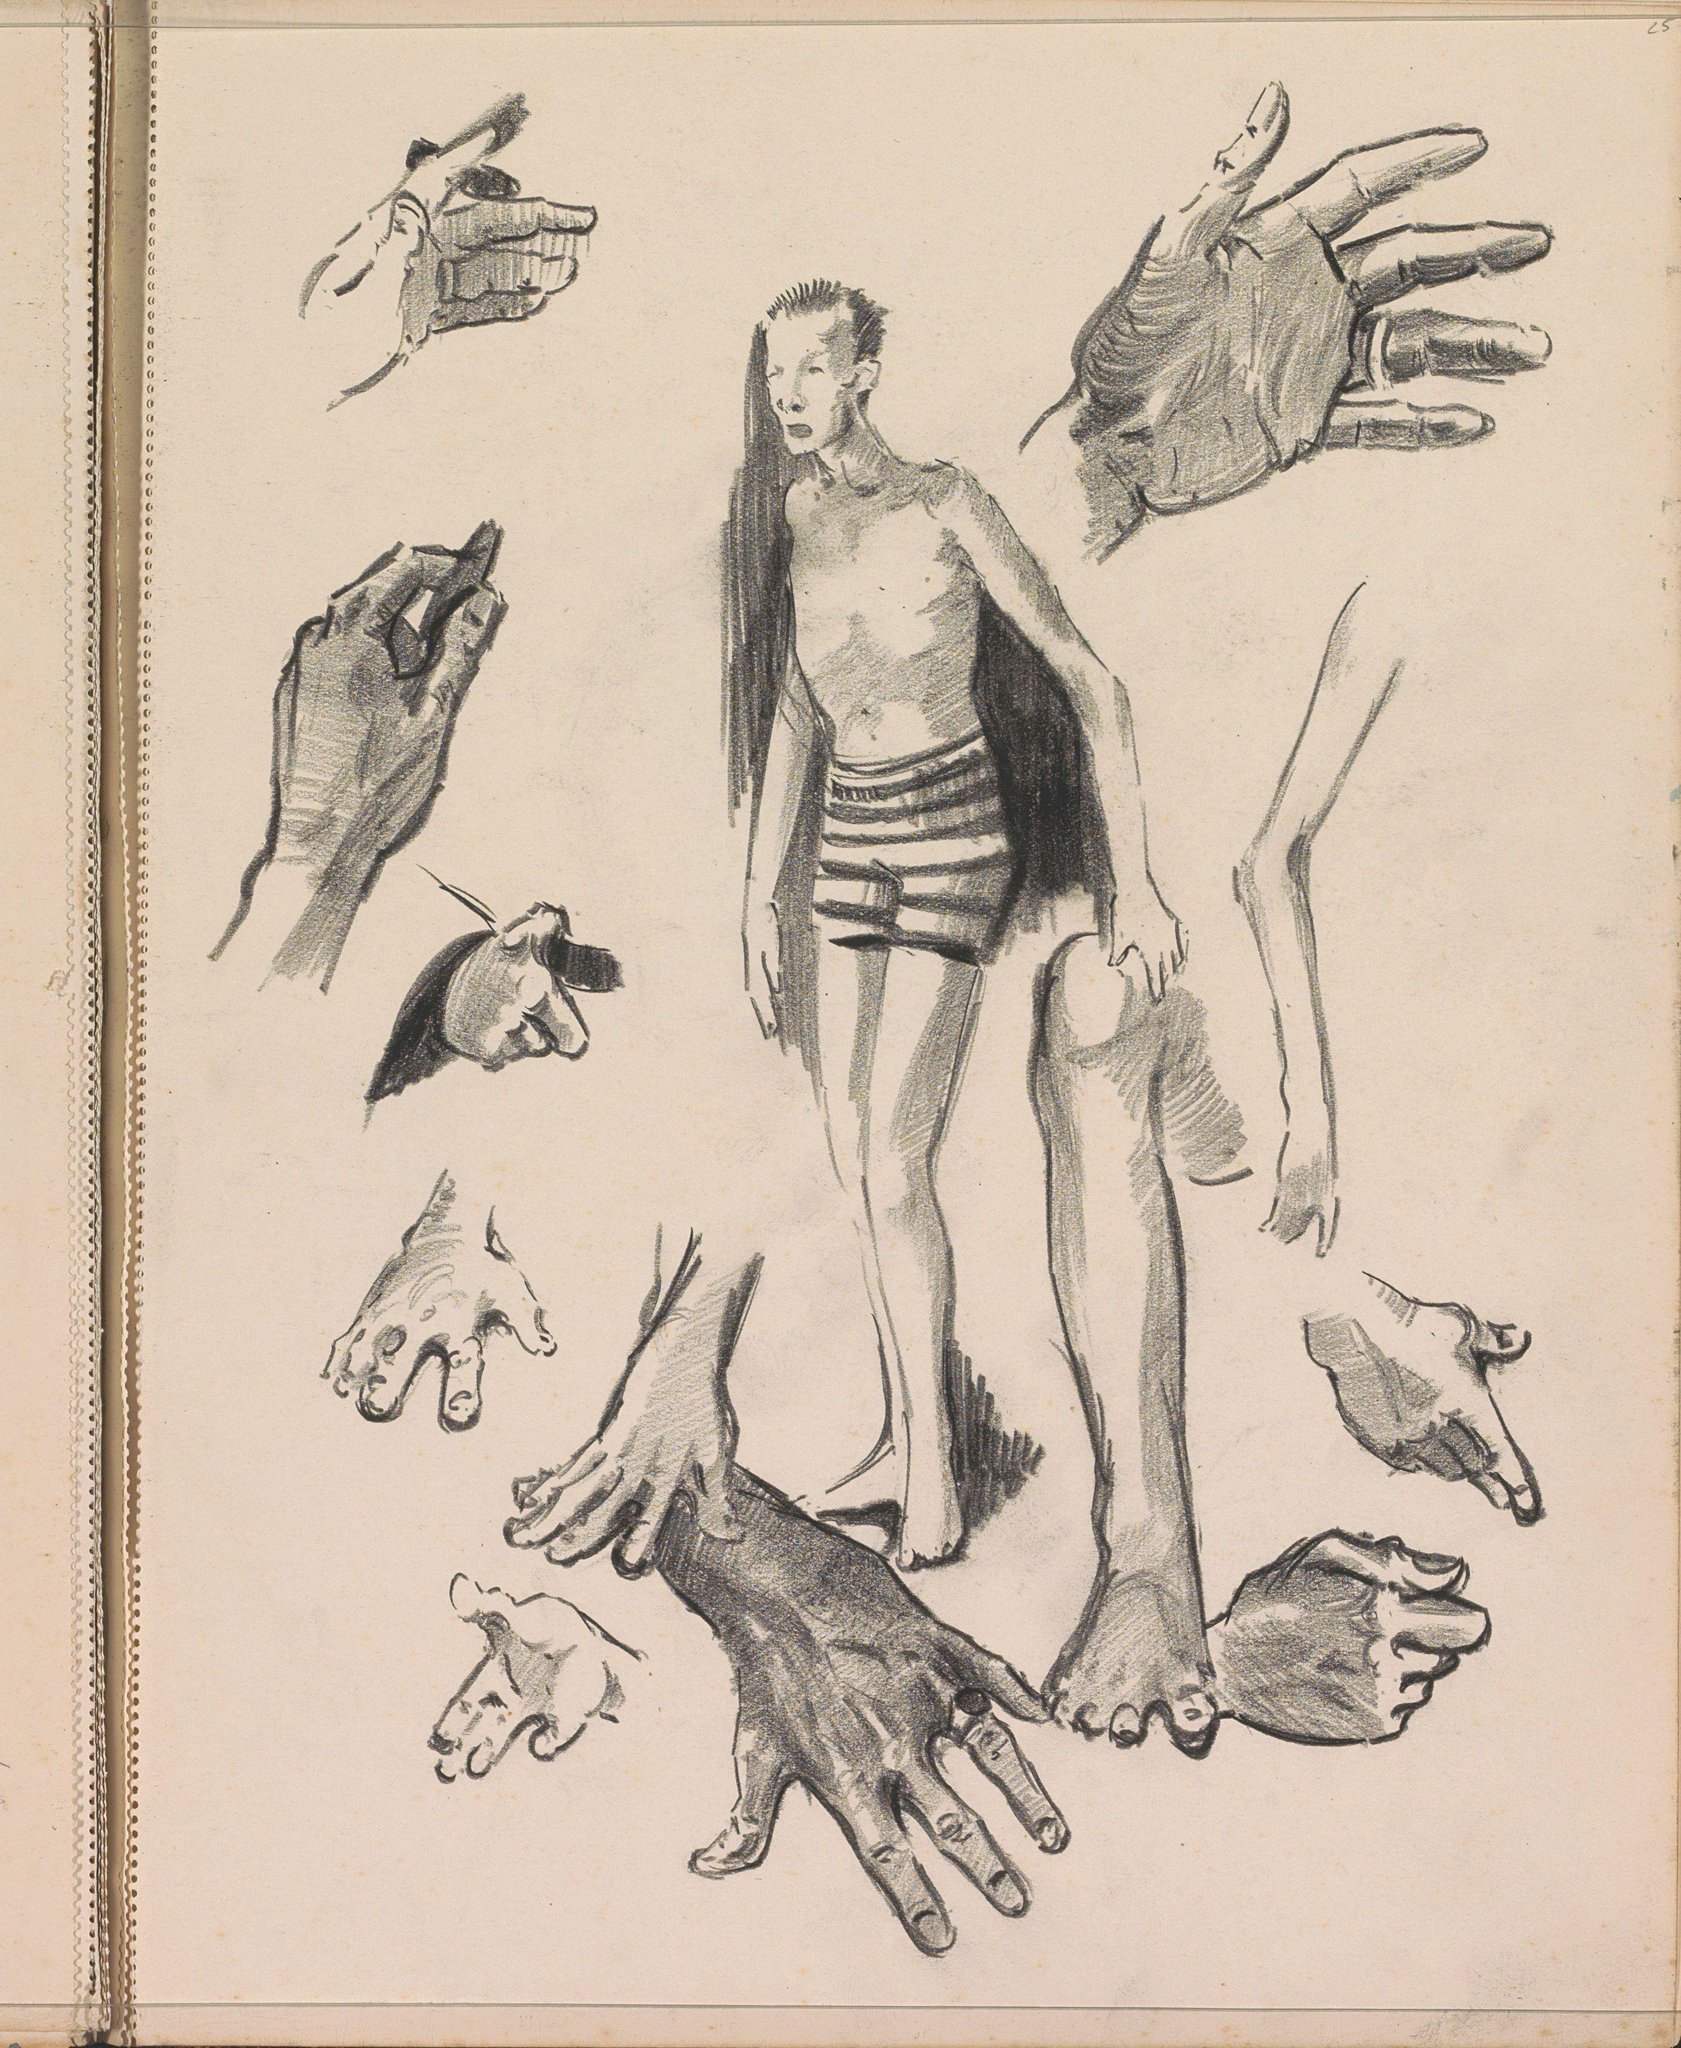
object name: sketchbook leaf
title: Handen en een staande man in een zwembroek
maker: otto verhagen (i)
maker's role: draughtsman, print maker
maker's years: 1885-1951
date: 1917-1919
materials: chalk, paper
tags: hand, swimming (sport) (+ sportsman, player, etc.)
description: Pagina 25 uit een schetsboek met 28 bladen.